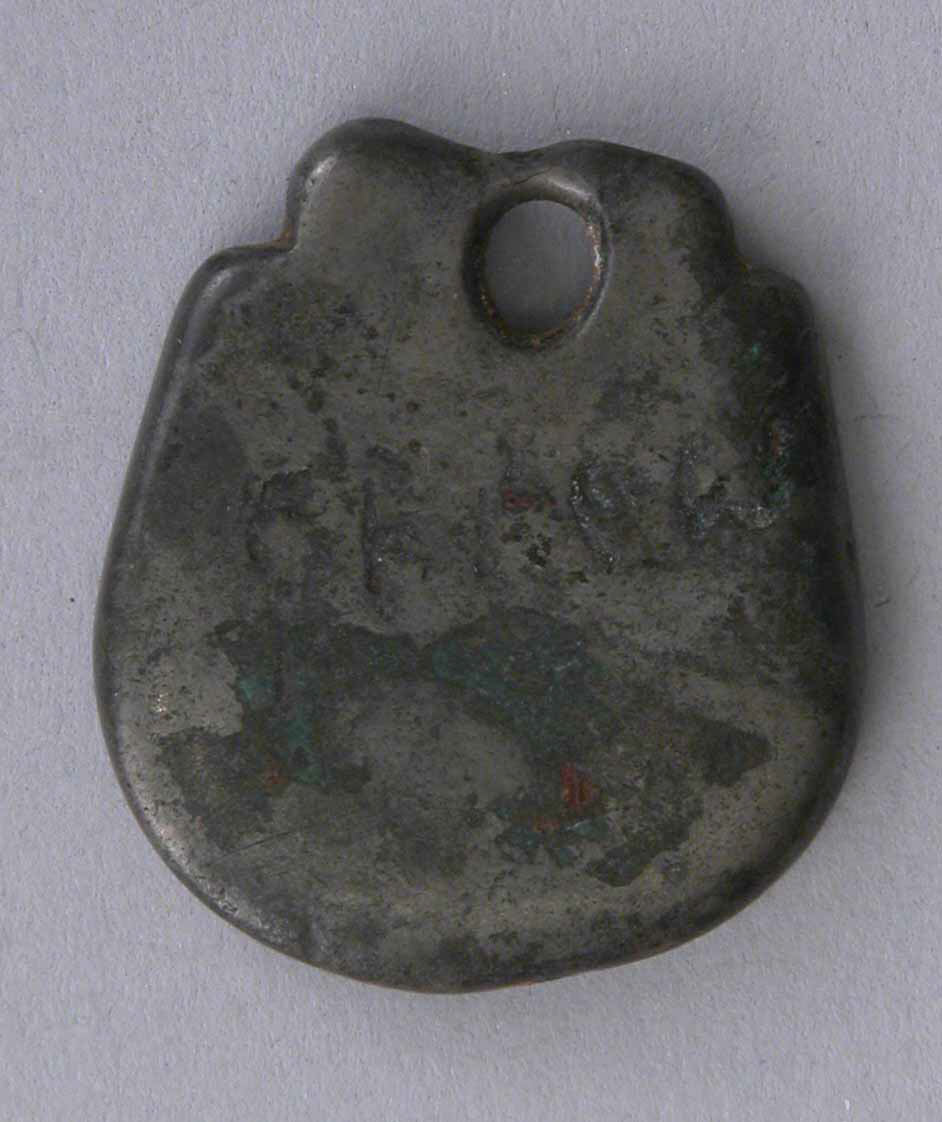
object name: pendant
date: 201-1200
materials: bronze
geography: egypt